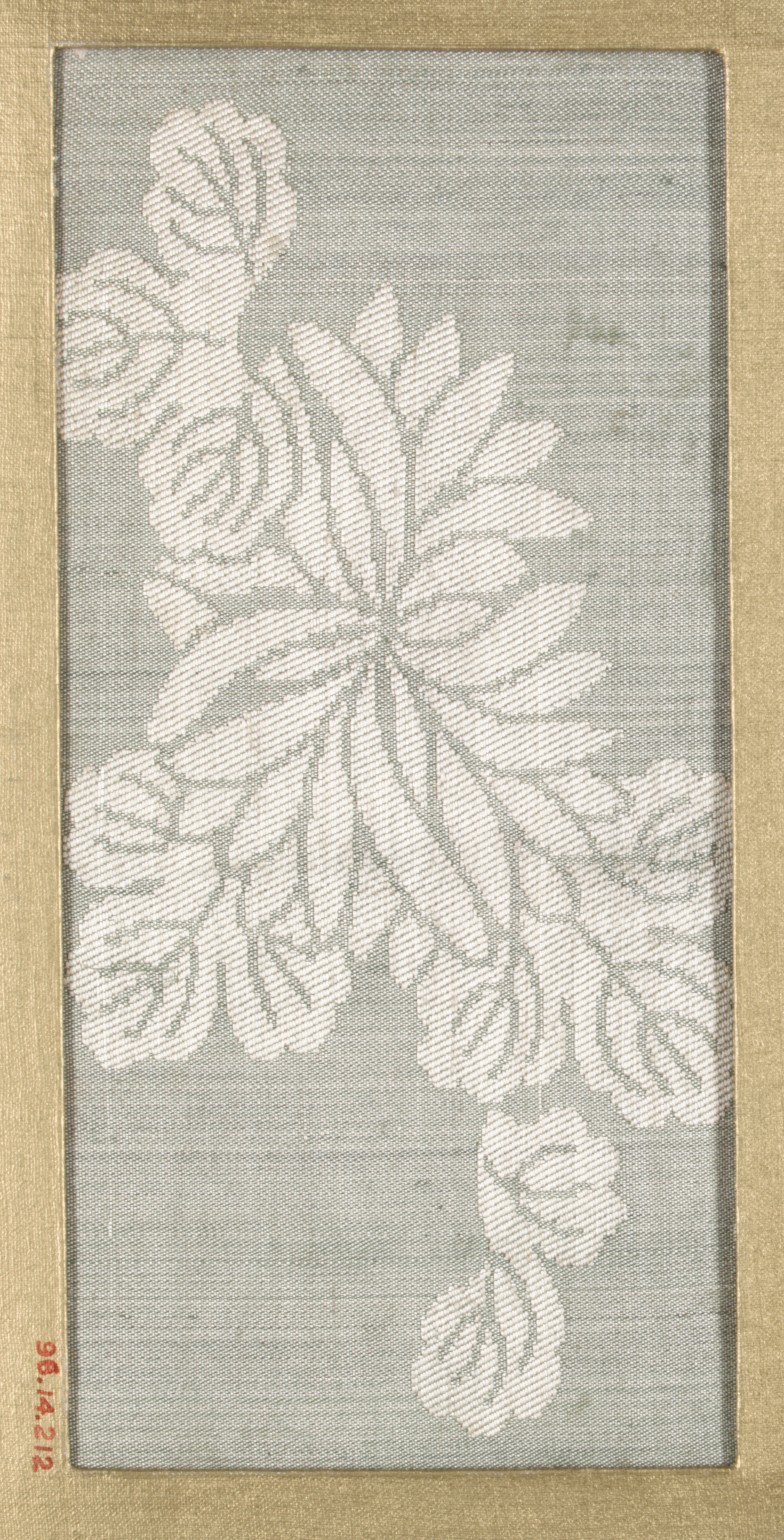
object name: piece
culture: japanese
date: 1701-1900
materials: silk